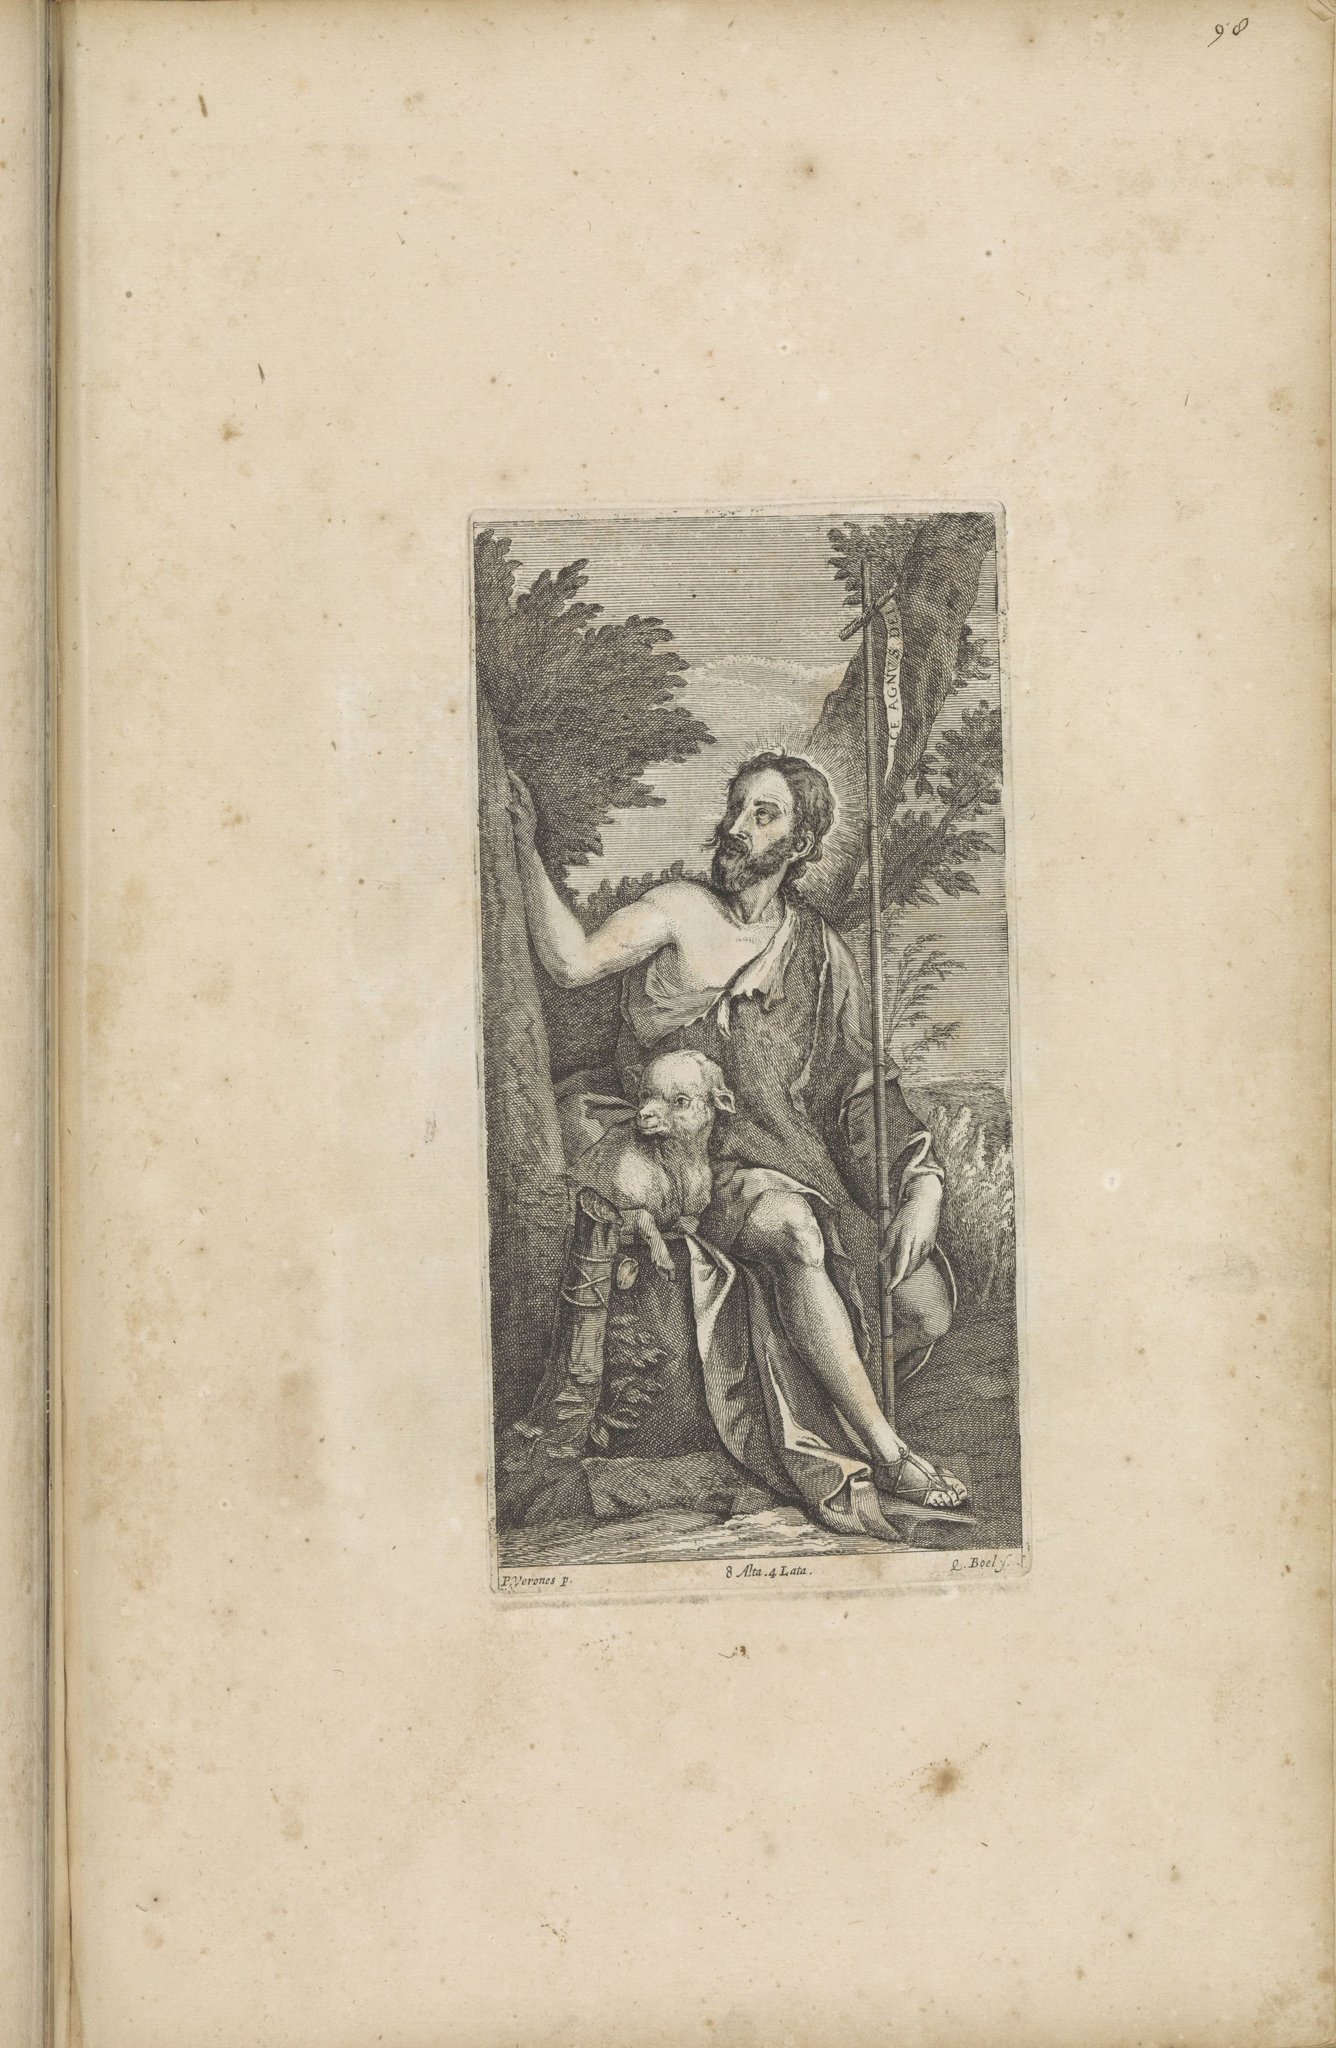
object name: print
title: H. Johannes de Doper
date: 1660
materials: paper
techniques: etching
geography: southern netherlands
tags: john the baptist; possible attributes: book, reed cross, baptismal cup, honeycomb, lamb, staff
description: De prent is vervaardigd naar het schilderij van Veronese dat zich in de collectie van het Kunsthistorisches Museum te Wenen bevindt (inventarisnummer GG_1545). David Teniers heeft waarschijnlijk van alle schilderijen uit de collectie van Leopold Willem van Oostenrijk een olieverfstudie op doek of paneel vervaardigd (zgn. pasticcio), die als voorbeeld voor de prentmakers diende. Het is niet altijd duidelijk of de pasticci door hem zijn gemaakt of door zijn atelier. Niet alle pasticci zijn overgeleverd.